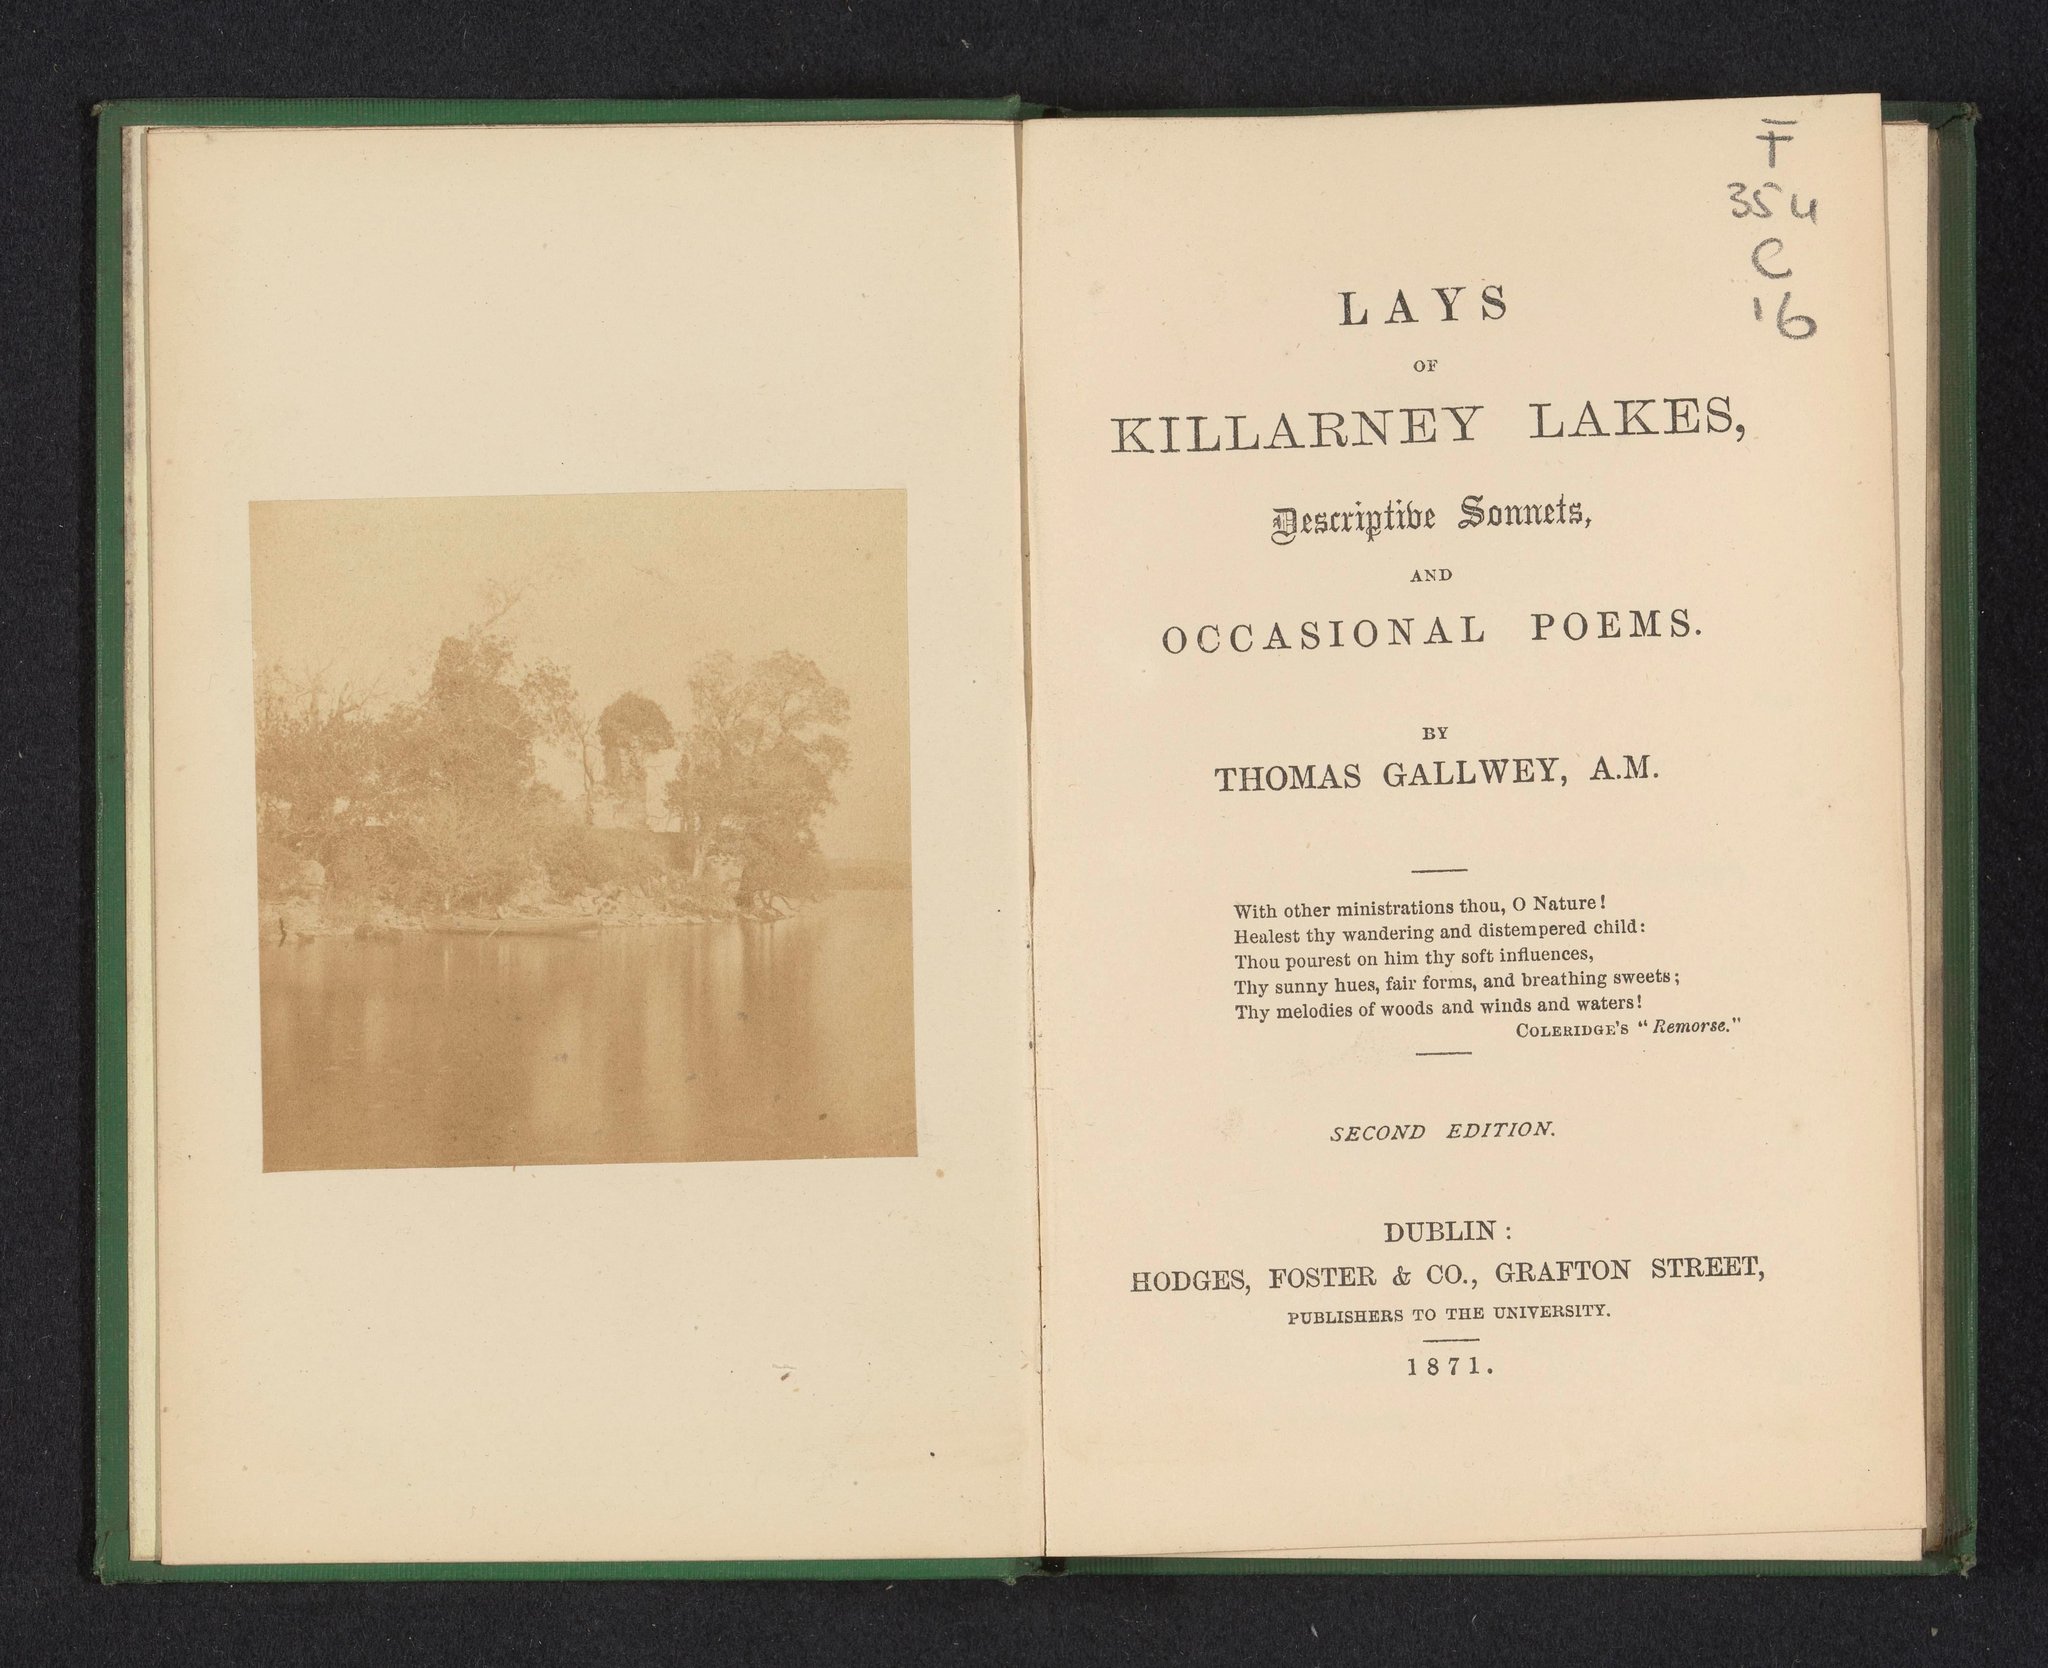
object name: photograph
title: Gezicht op Innisfallen Island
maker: Anonymous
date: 1861-1871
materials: photographic support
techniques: albumen print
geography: innisfallen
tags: island